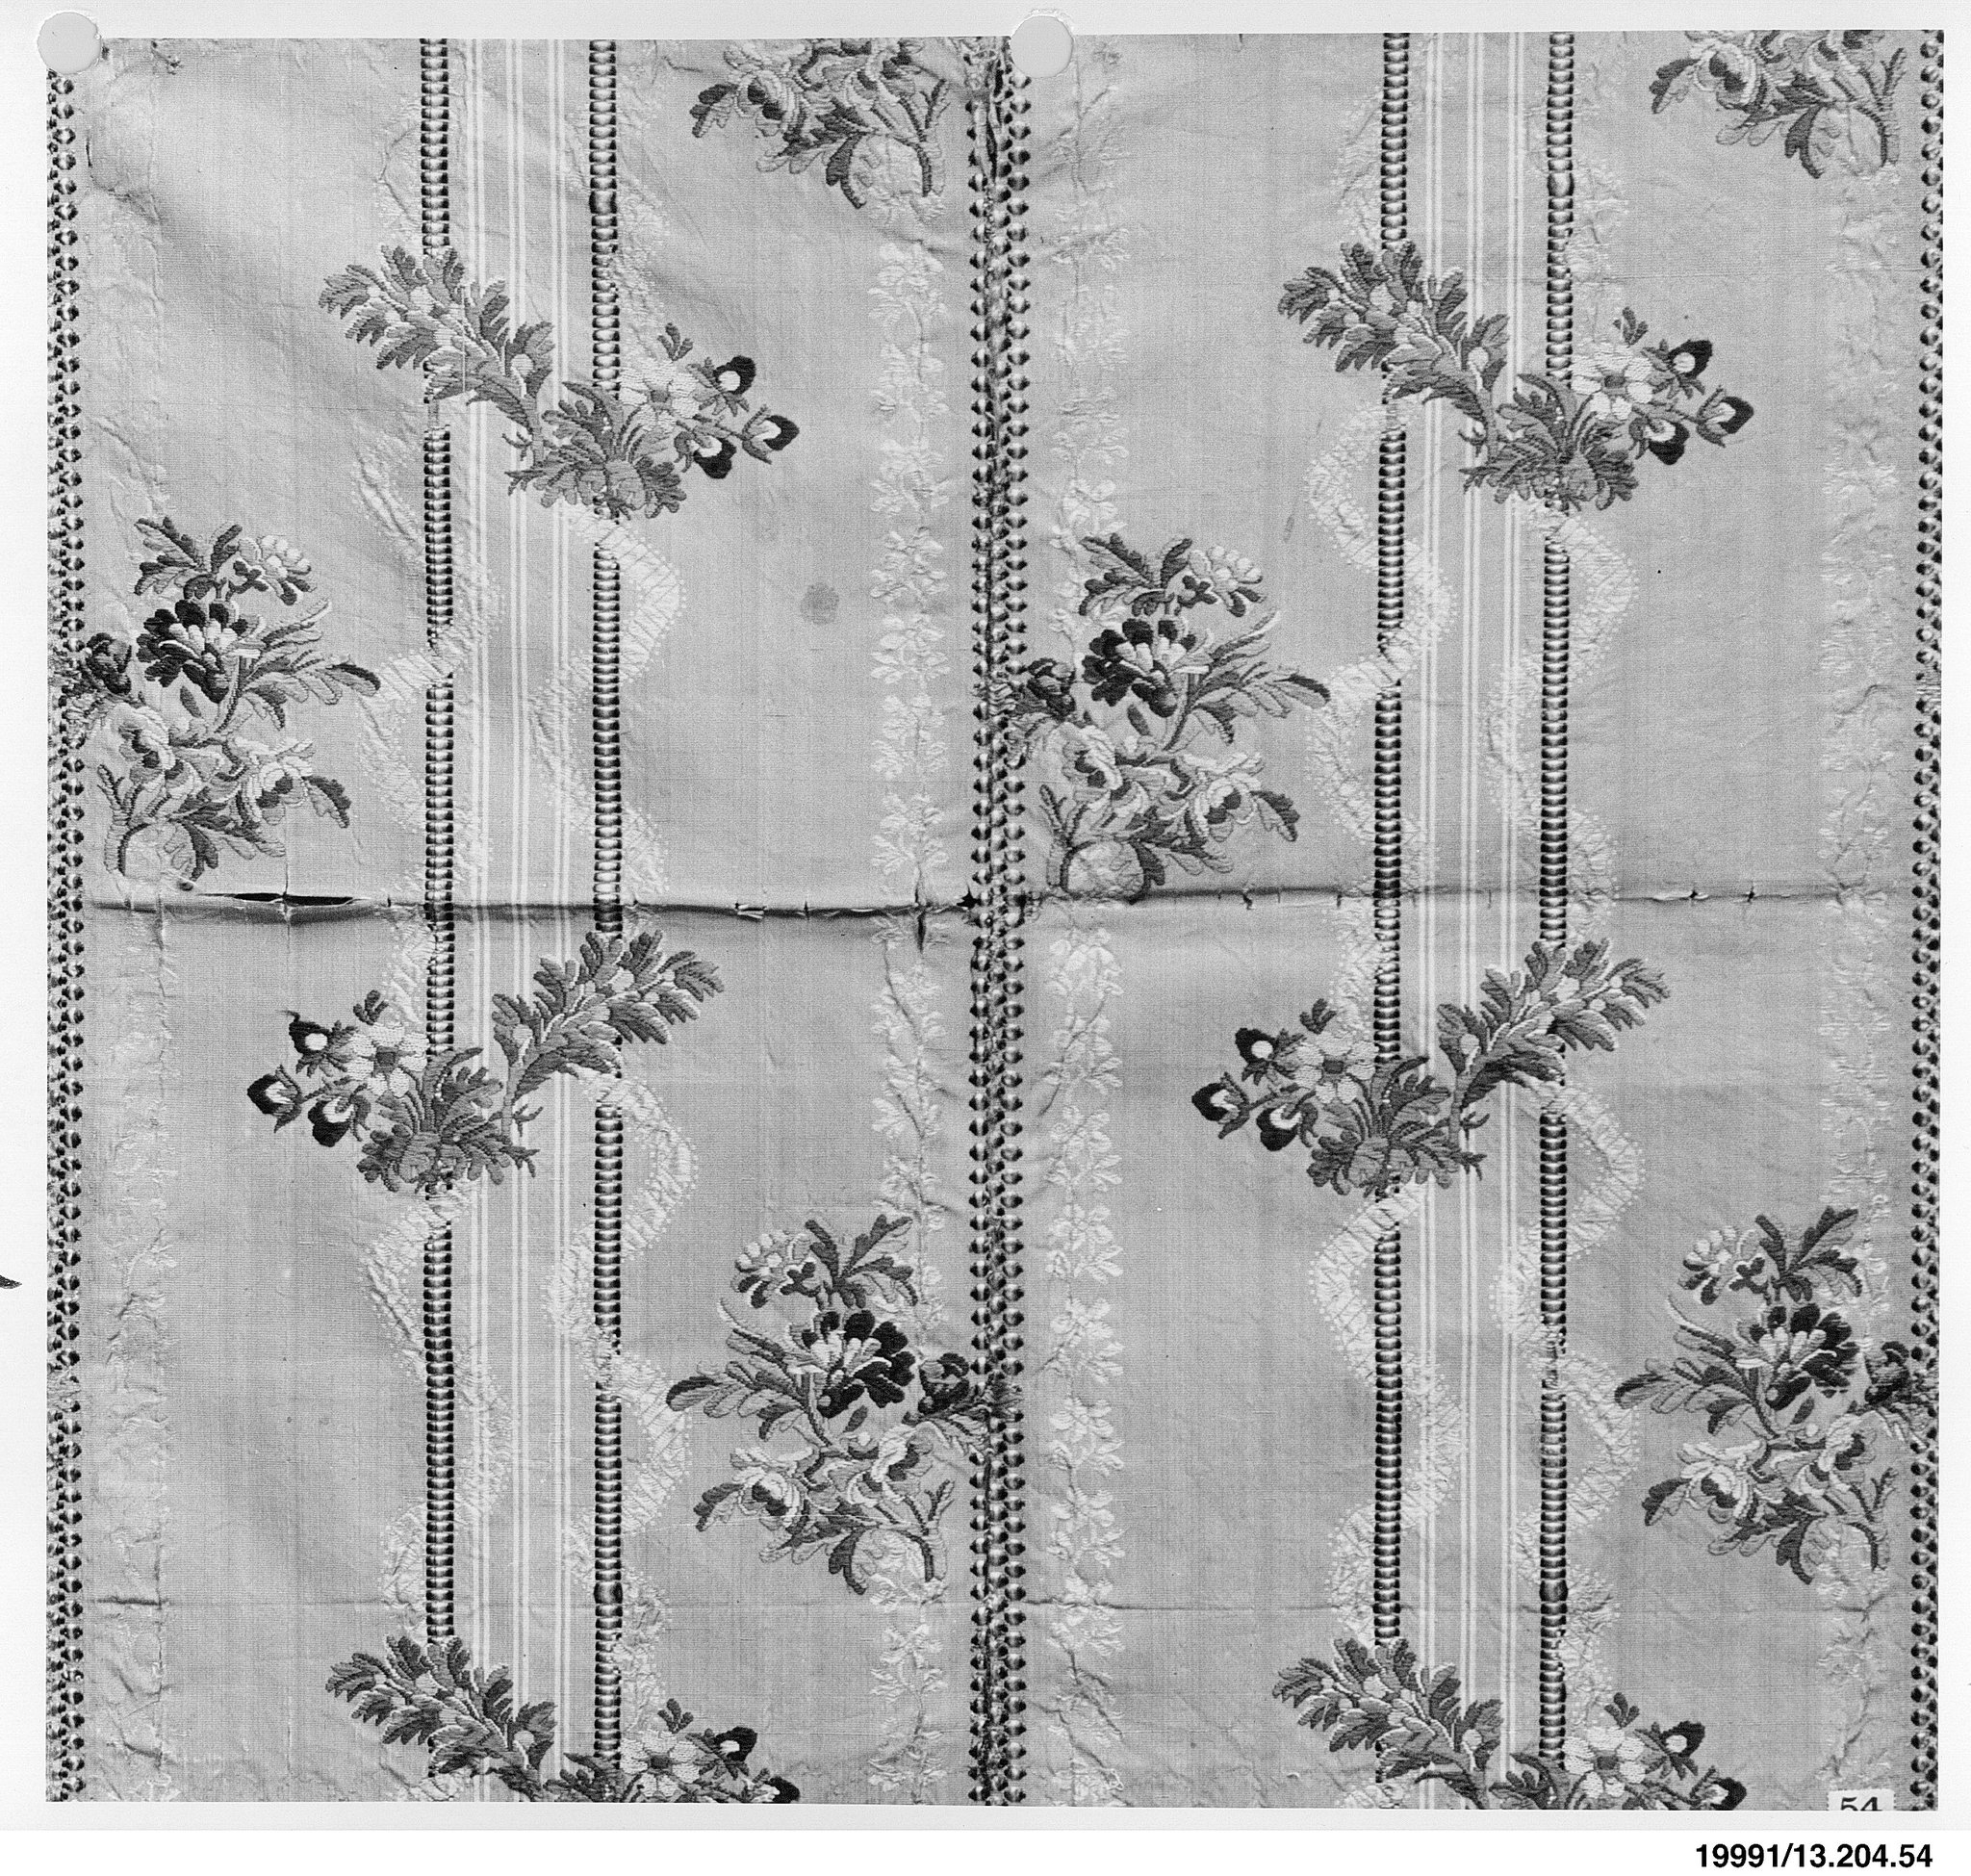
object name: piece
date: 1775-1790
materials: silk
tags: leaves